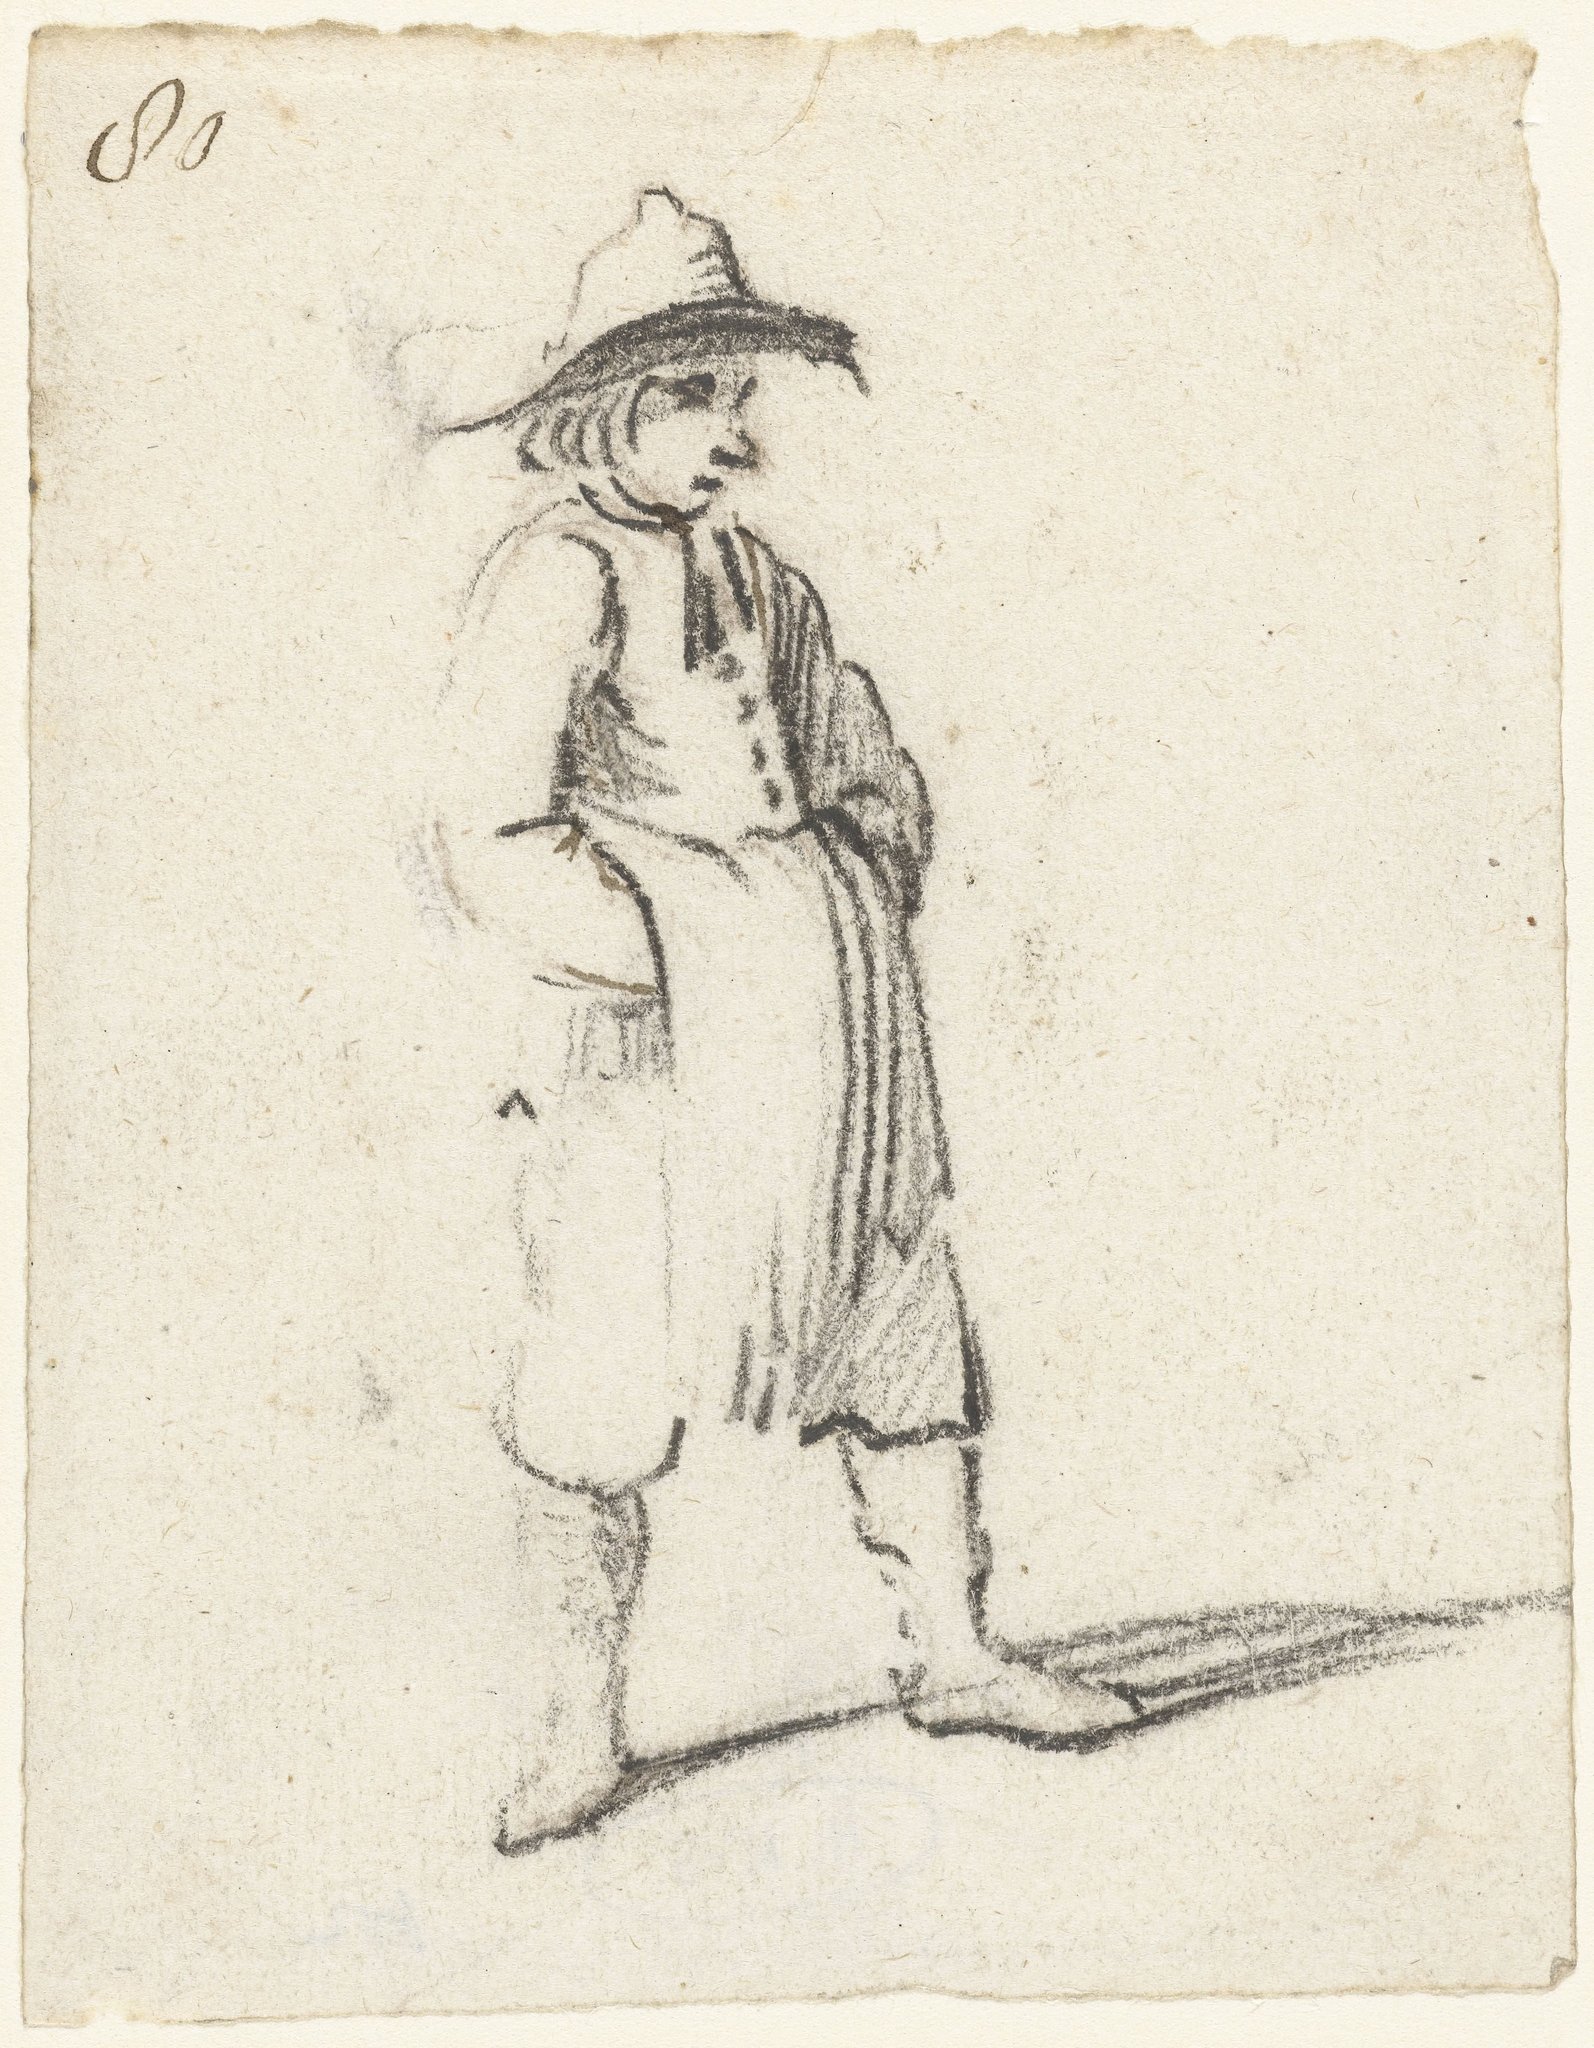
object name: drawing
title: Jongen met zijn handen onder een schort, naar rechts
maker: harmen ter borch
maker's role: draughtsman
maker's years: 1638-1677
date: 1611-1651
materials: chalk, paper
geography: zwolle